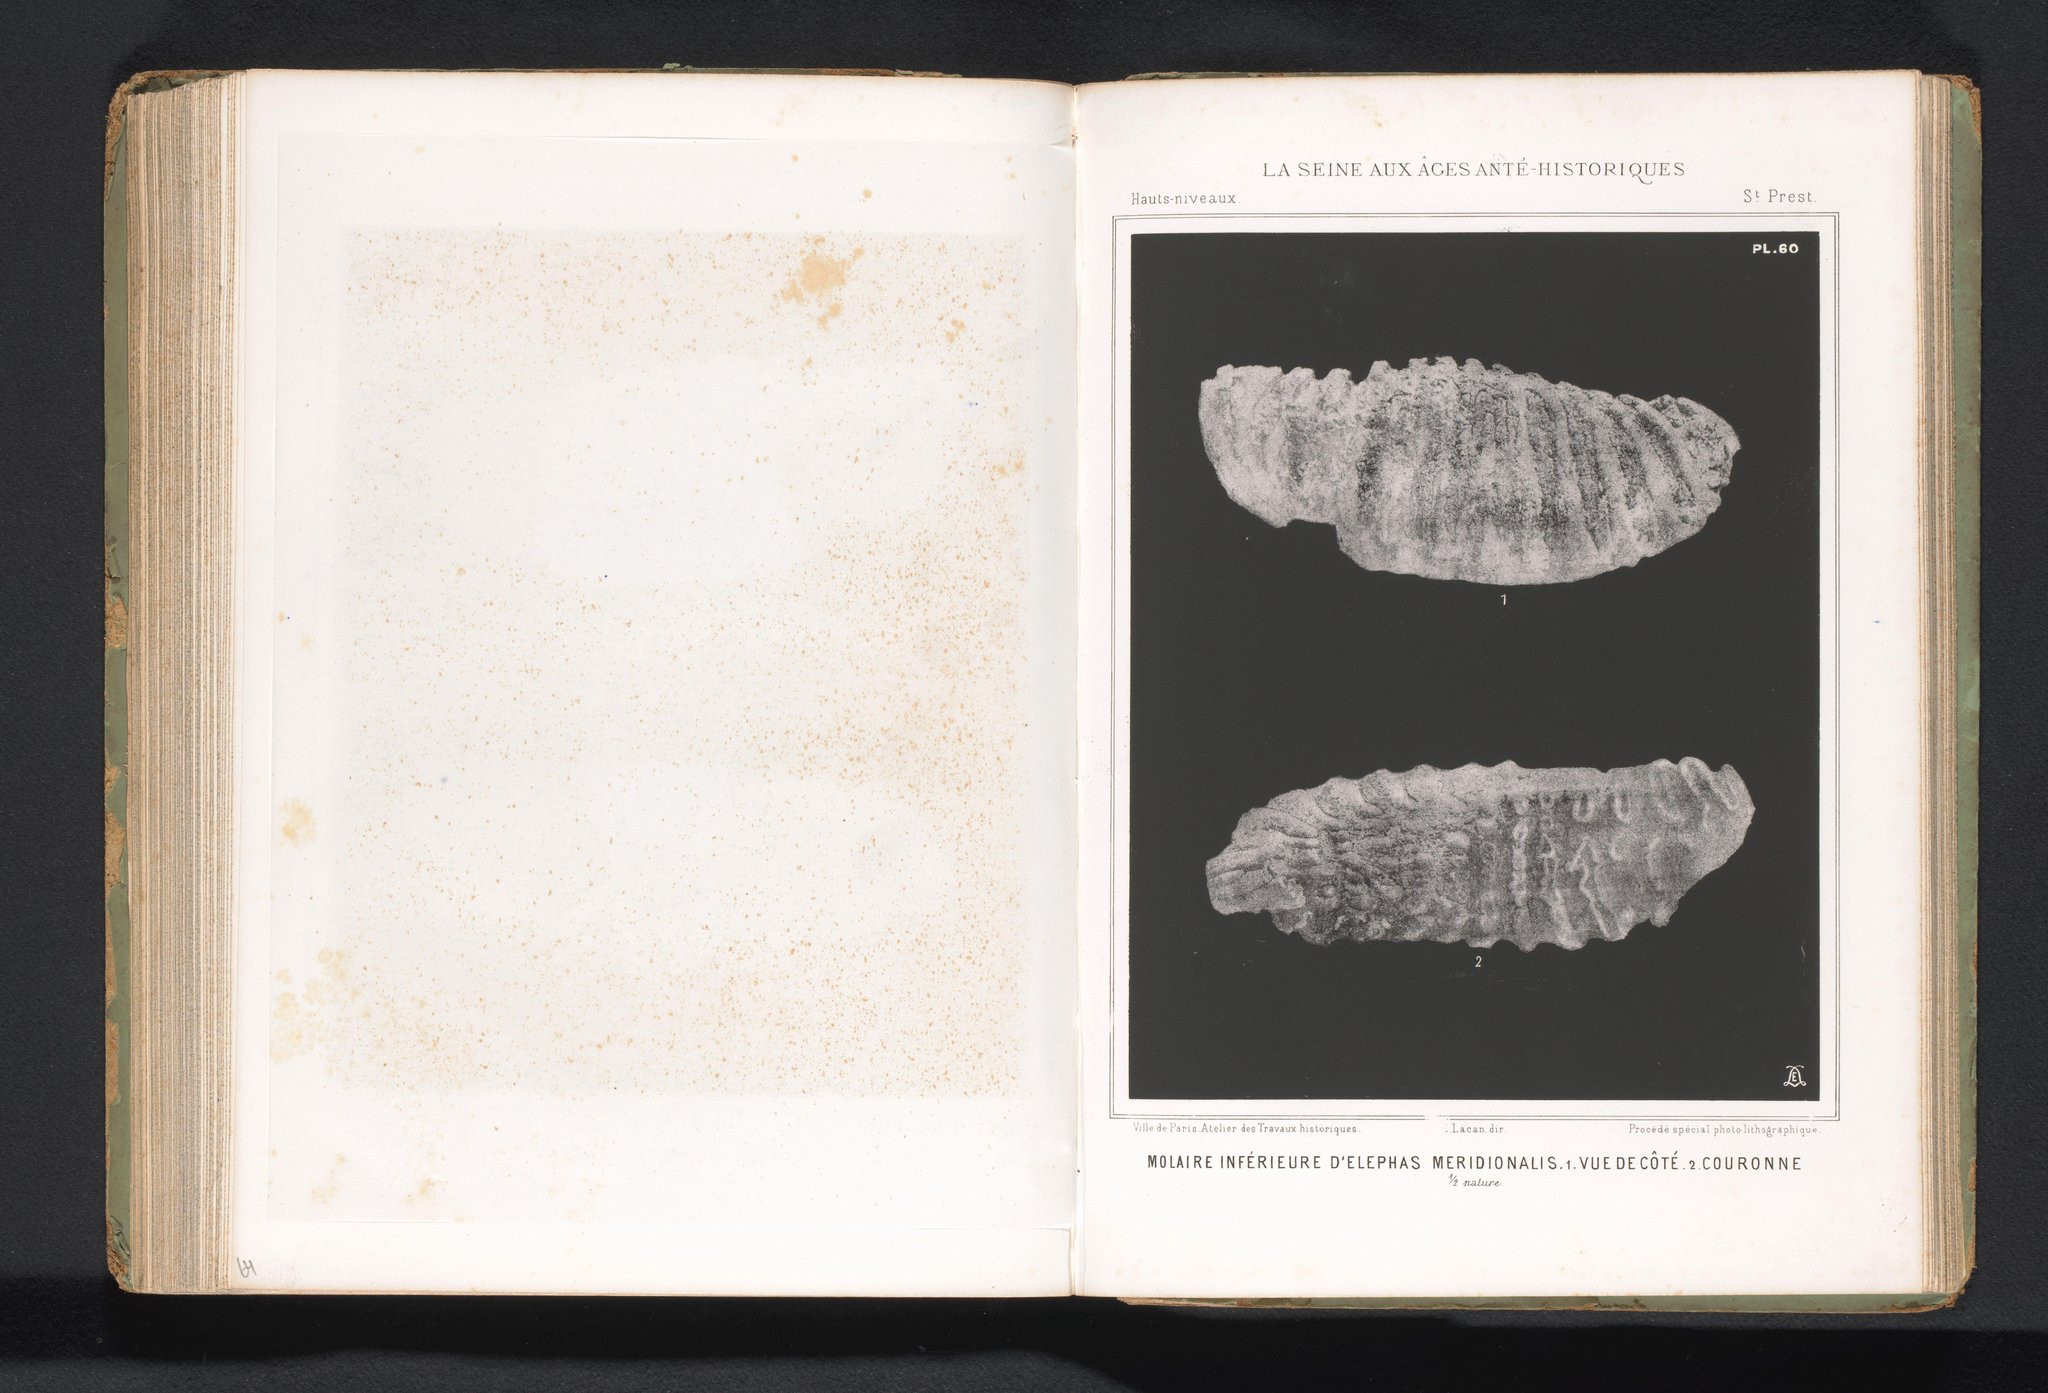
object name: page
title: Kies van een zuidelijke olifant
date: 1864-1869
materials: paper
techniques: photolithography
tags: mammals (+ skeleton of an animal)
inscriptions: inscription: ‘1/2 nature’, inscription: ‘PL.60’, monogram: ‘EL’, inscription: ‘MOLAIRE INFÉRIEURE D'ELEPHAS MERIDIONALIS. 1. VUE DE CÔTÉ . 2. COURONNE’, inscription: ‘Procédé spécial photo-lithographique’